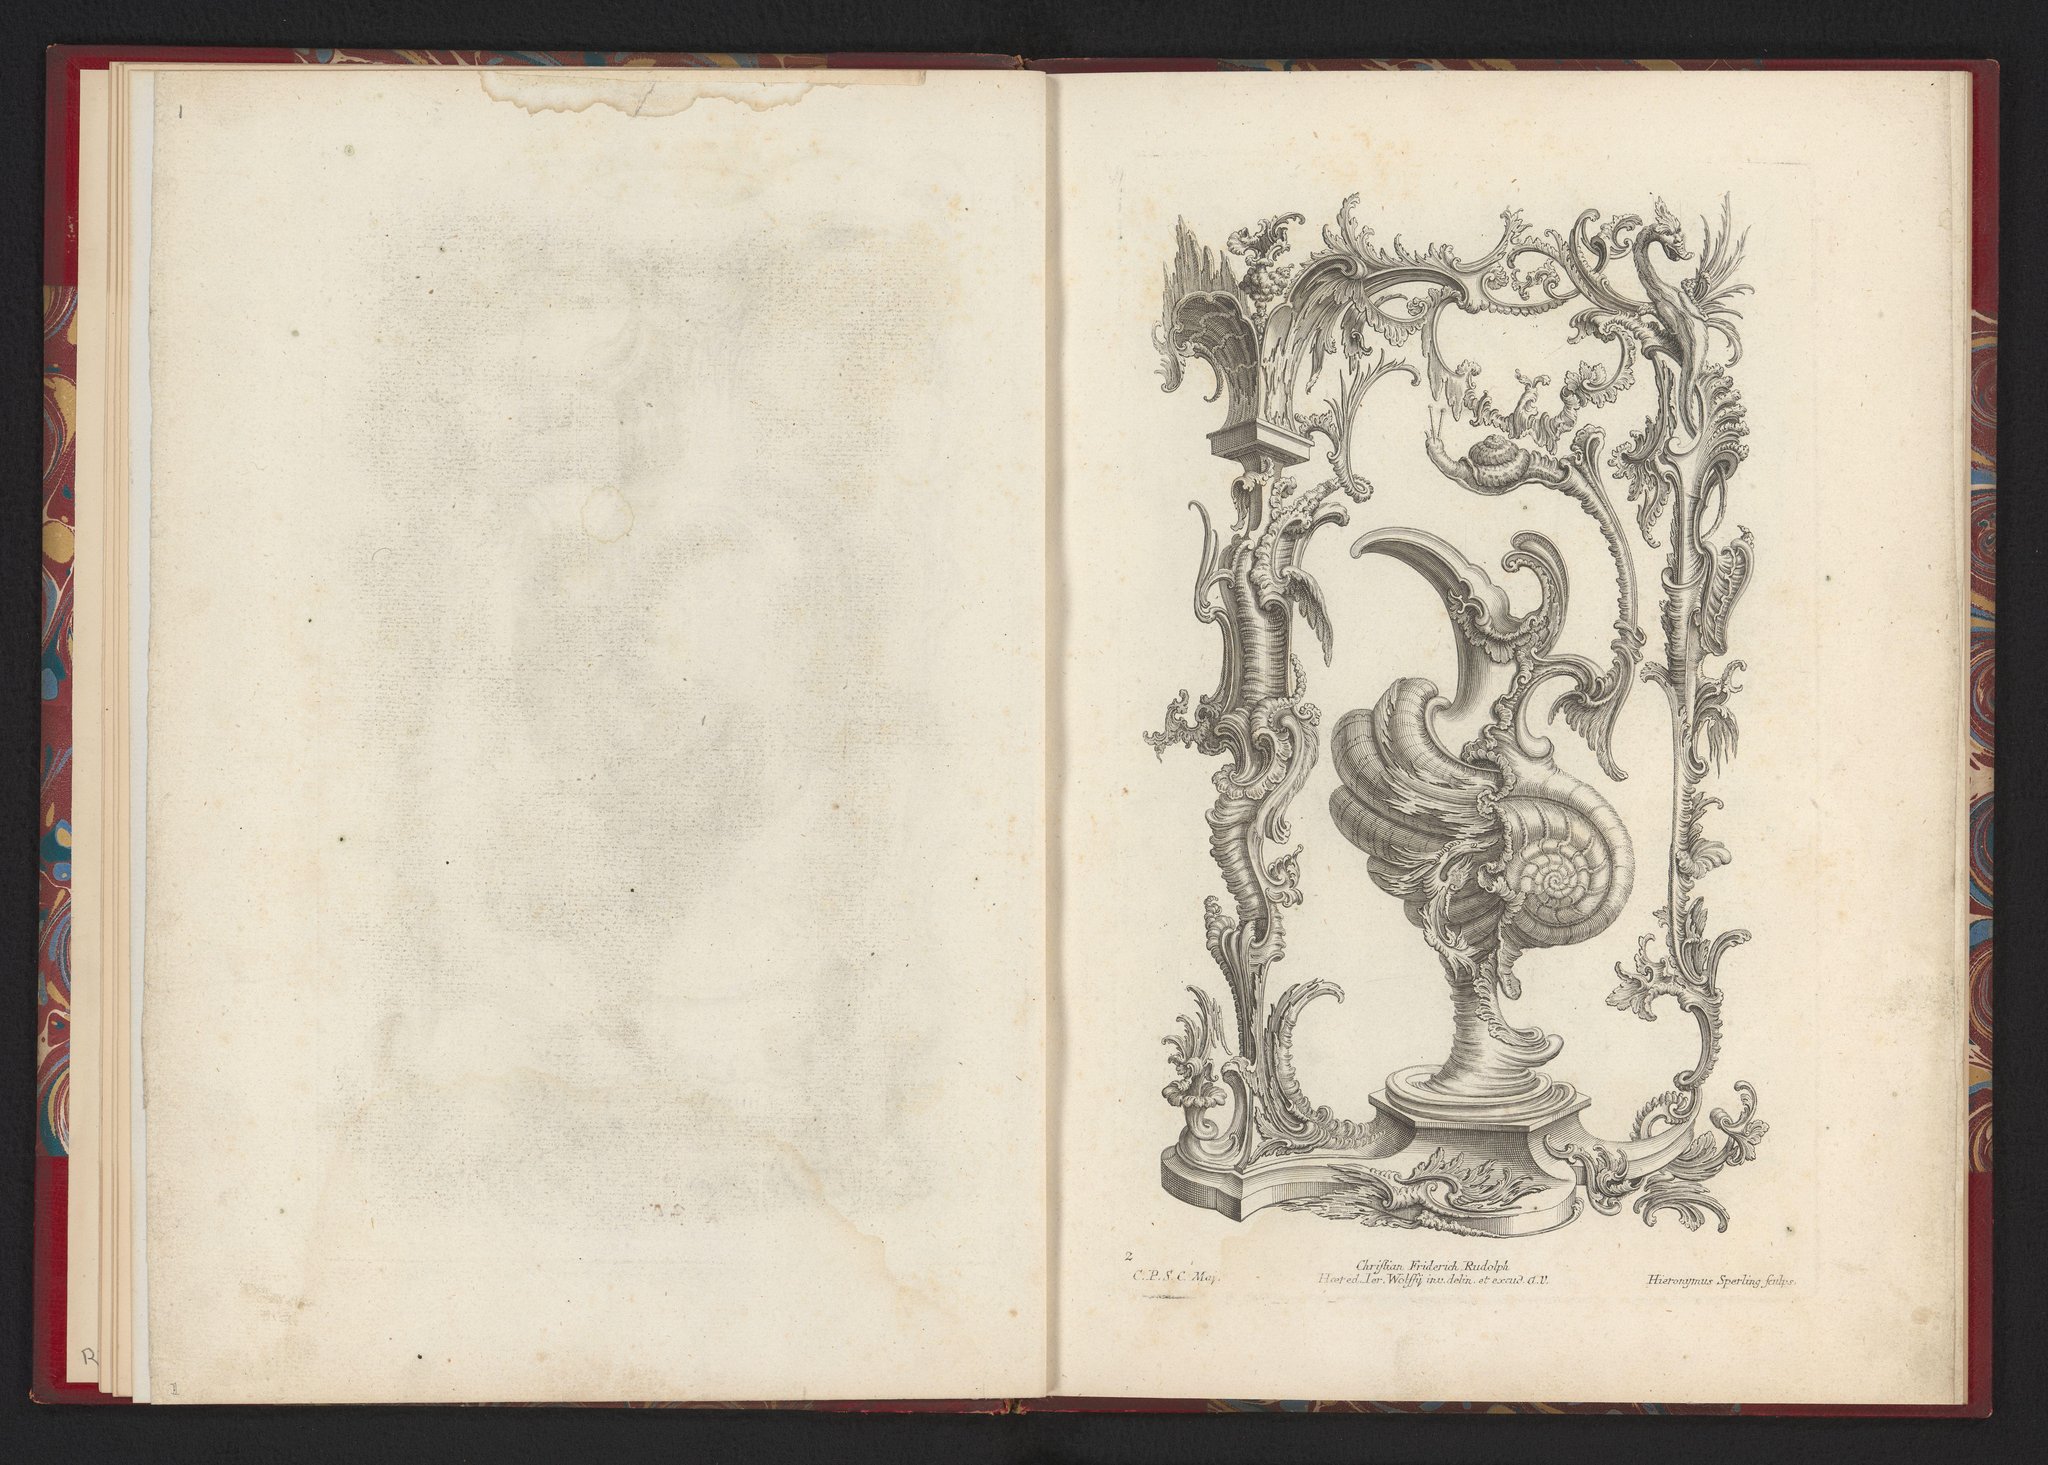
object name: print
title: Siervazen en -kannen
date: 1750-1770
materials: paper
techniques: etching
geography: augsburg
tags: ornaments ~ art, rocaille ornament, vase ~ ornament, jar, jug (used as drinking-vessel), molluscs: snail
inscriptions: signature: ‘C.P.S.C. Maj.’, signature: ‘Hieronymus Sperling Sculps.’, number: ‘2’, signature: ‘Christian Friderich Rudolph / Hoered. Ier. Wolffij inv. delin. et excud. A.V.’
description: Een sierkan met een slakkenhuis en een slak. Prent maakt deel uit van een album.